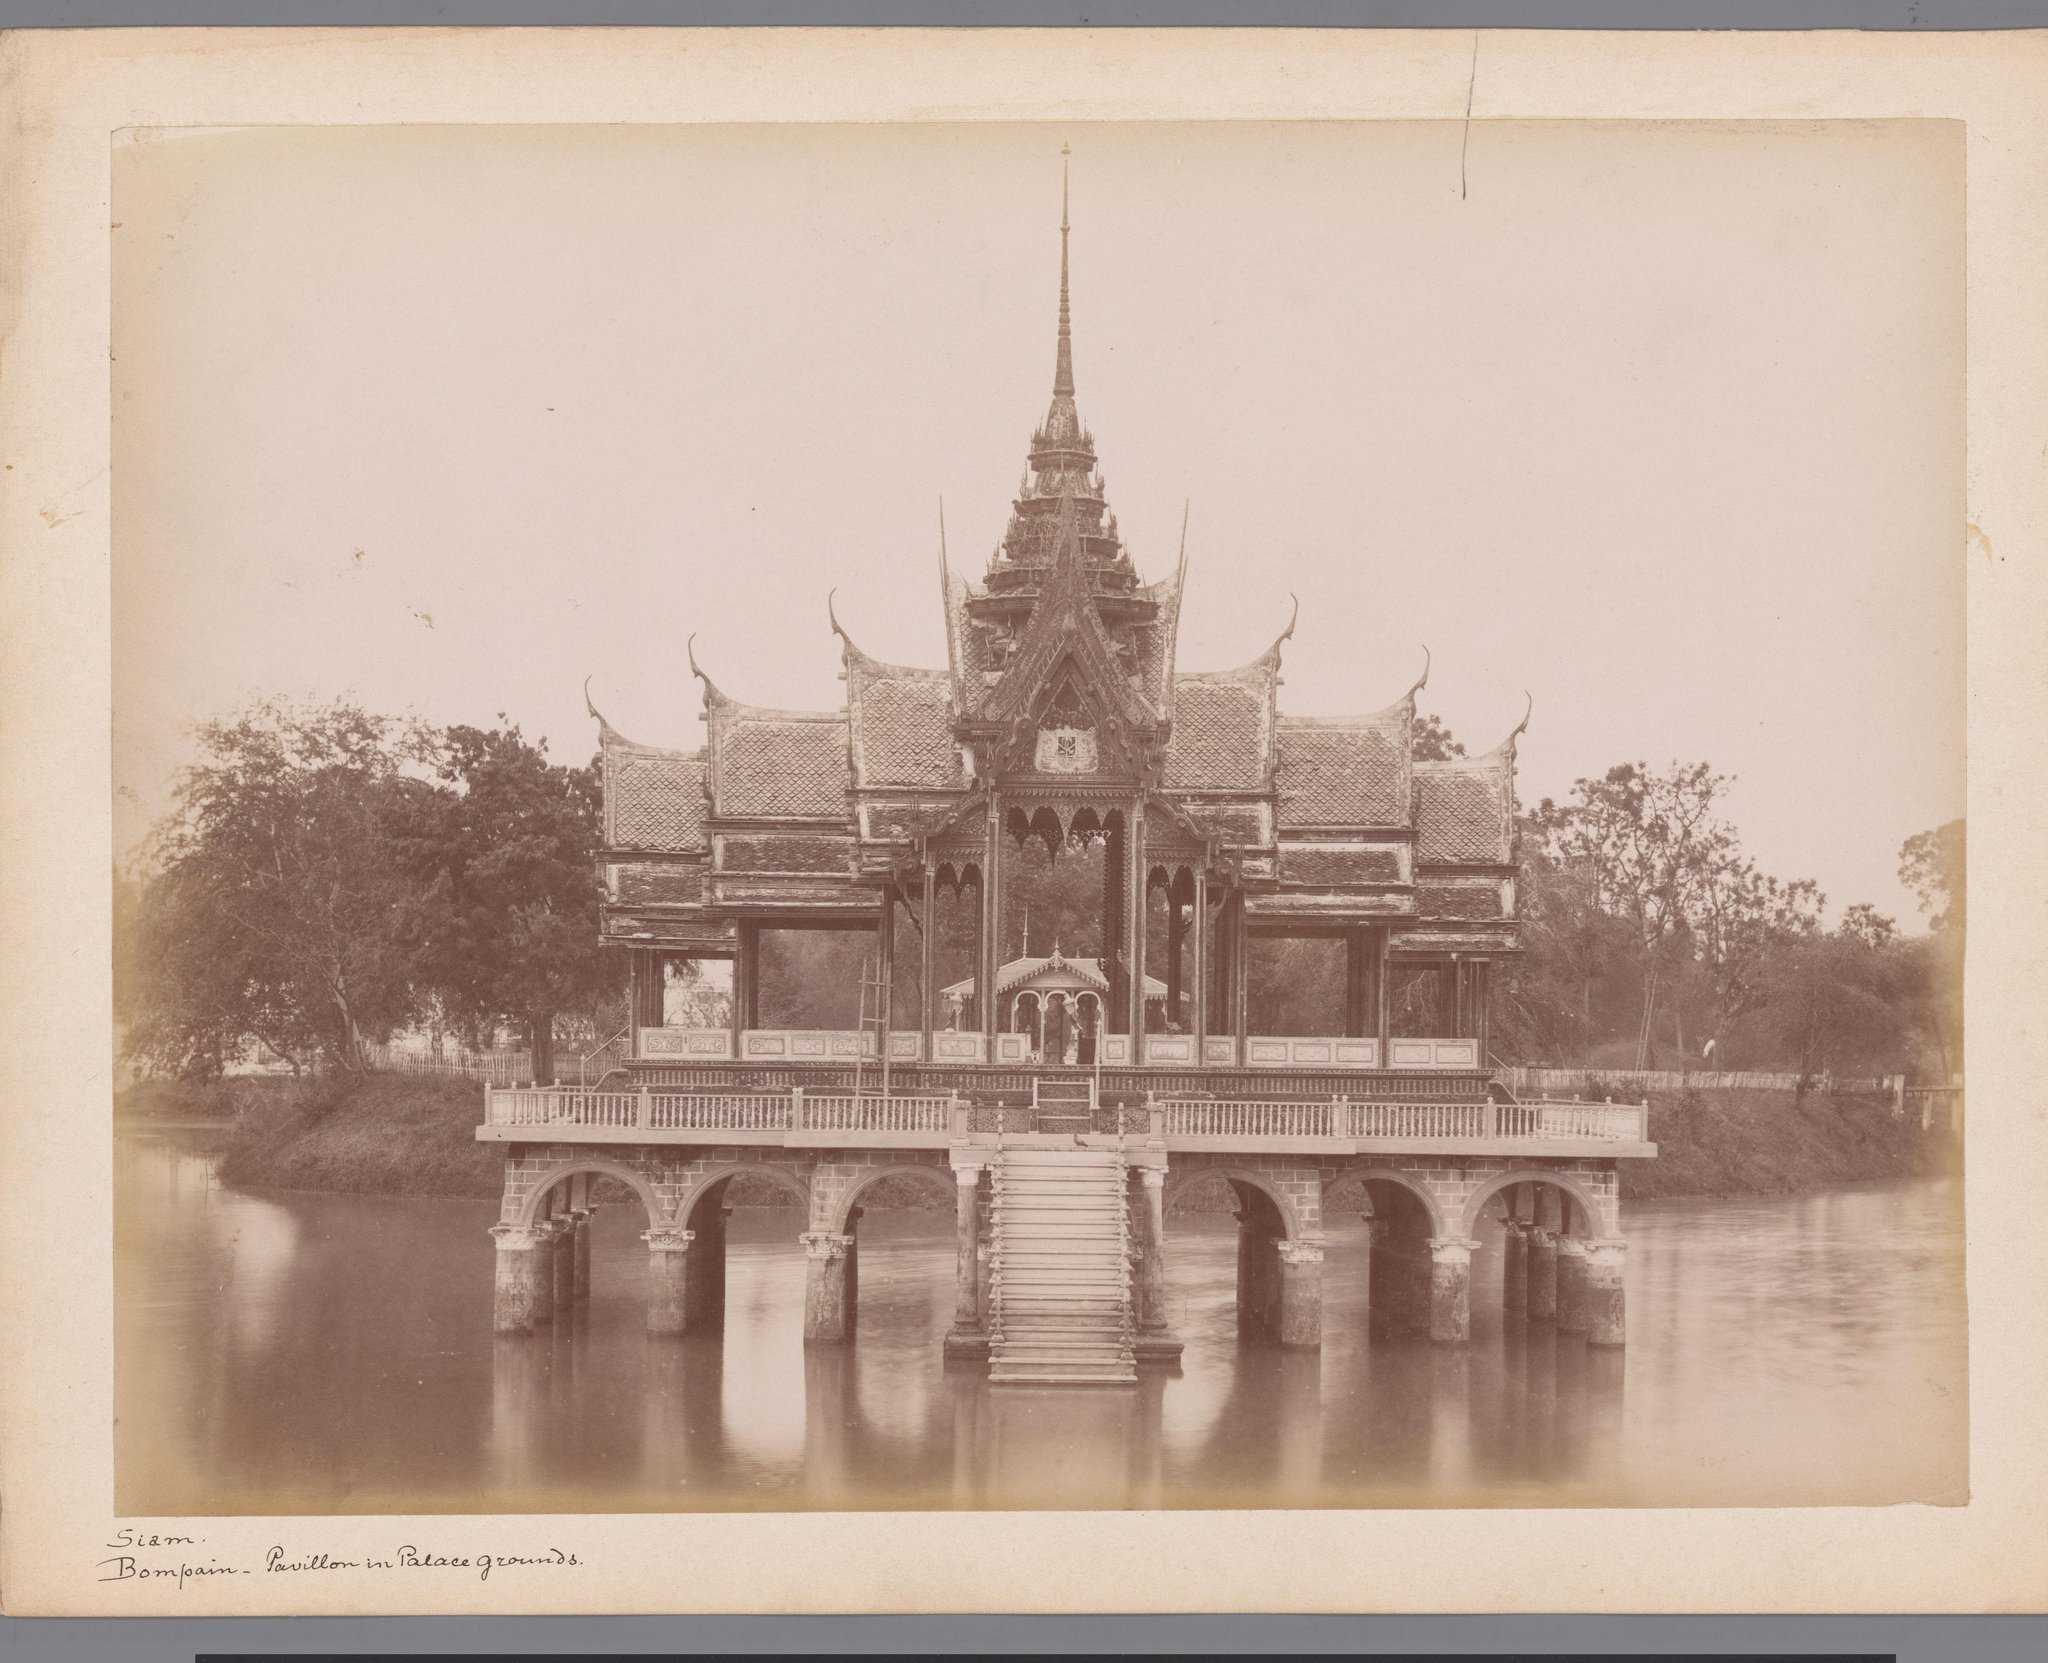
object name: photograph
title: Siam, Bompain-Pavillon in Palace grounds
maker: Anonymous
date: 1860-1900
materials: cardboard, paper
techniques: albumen print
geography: bang pa-in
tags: palace